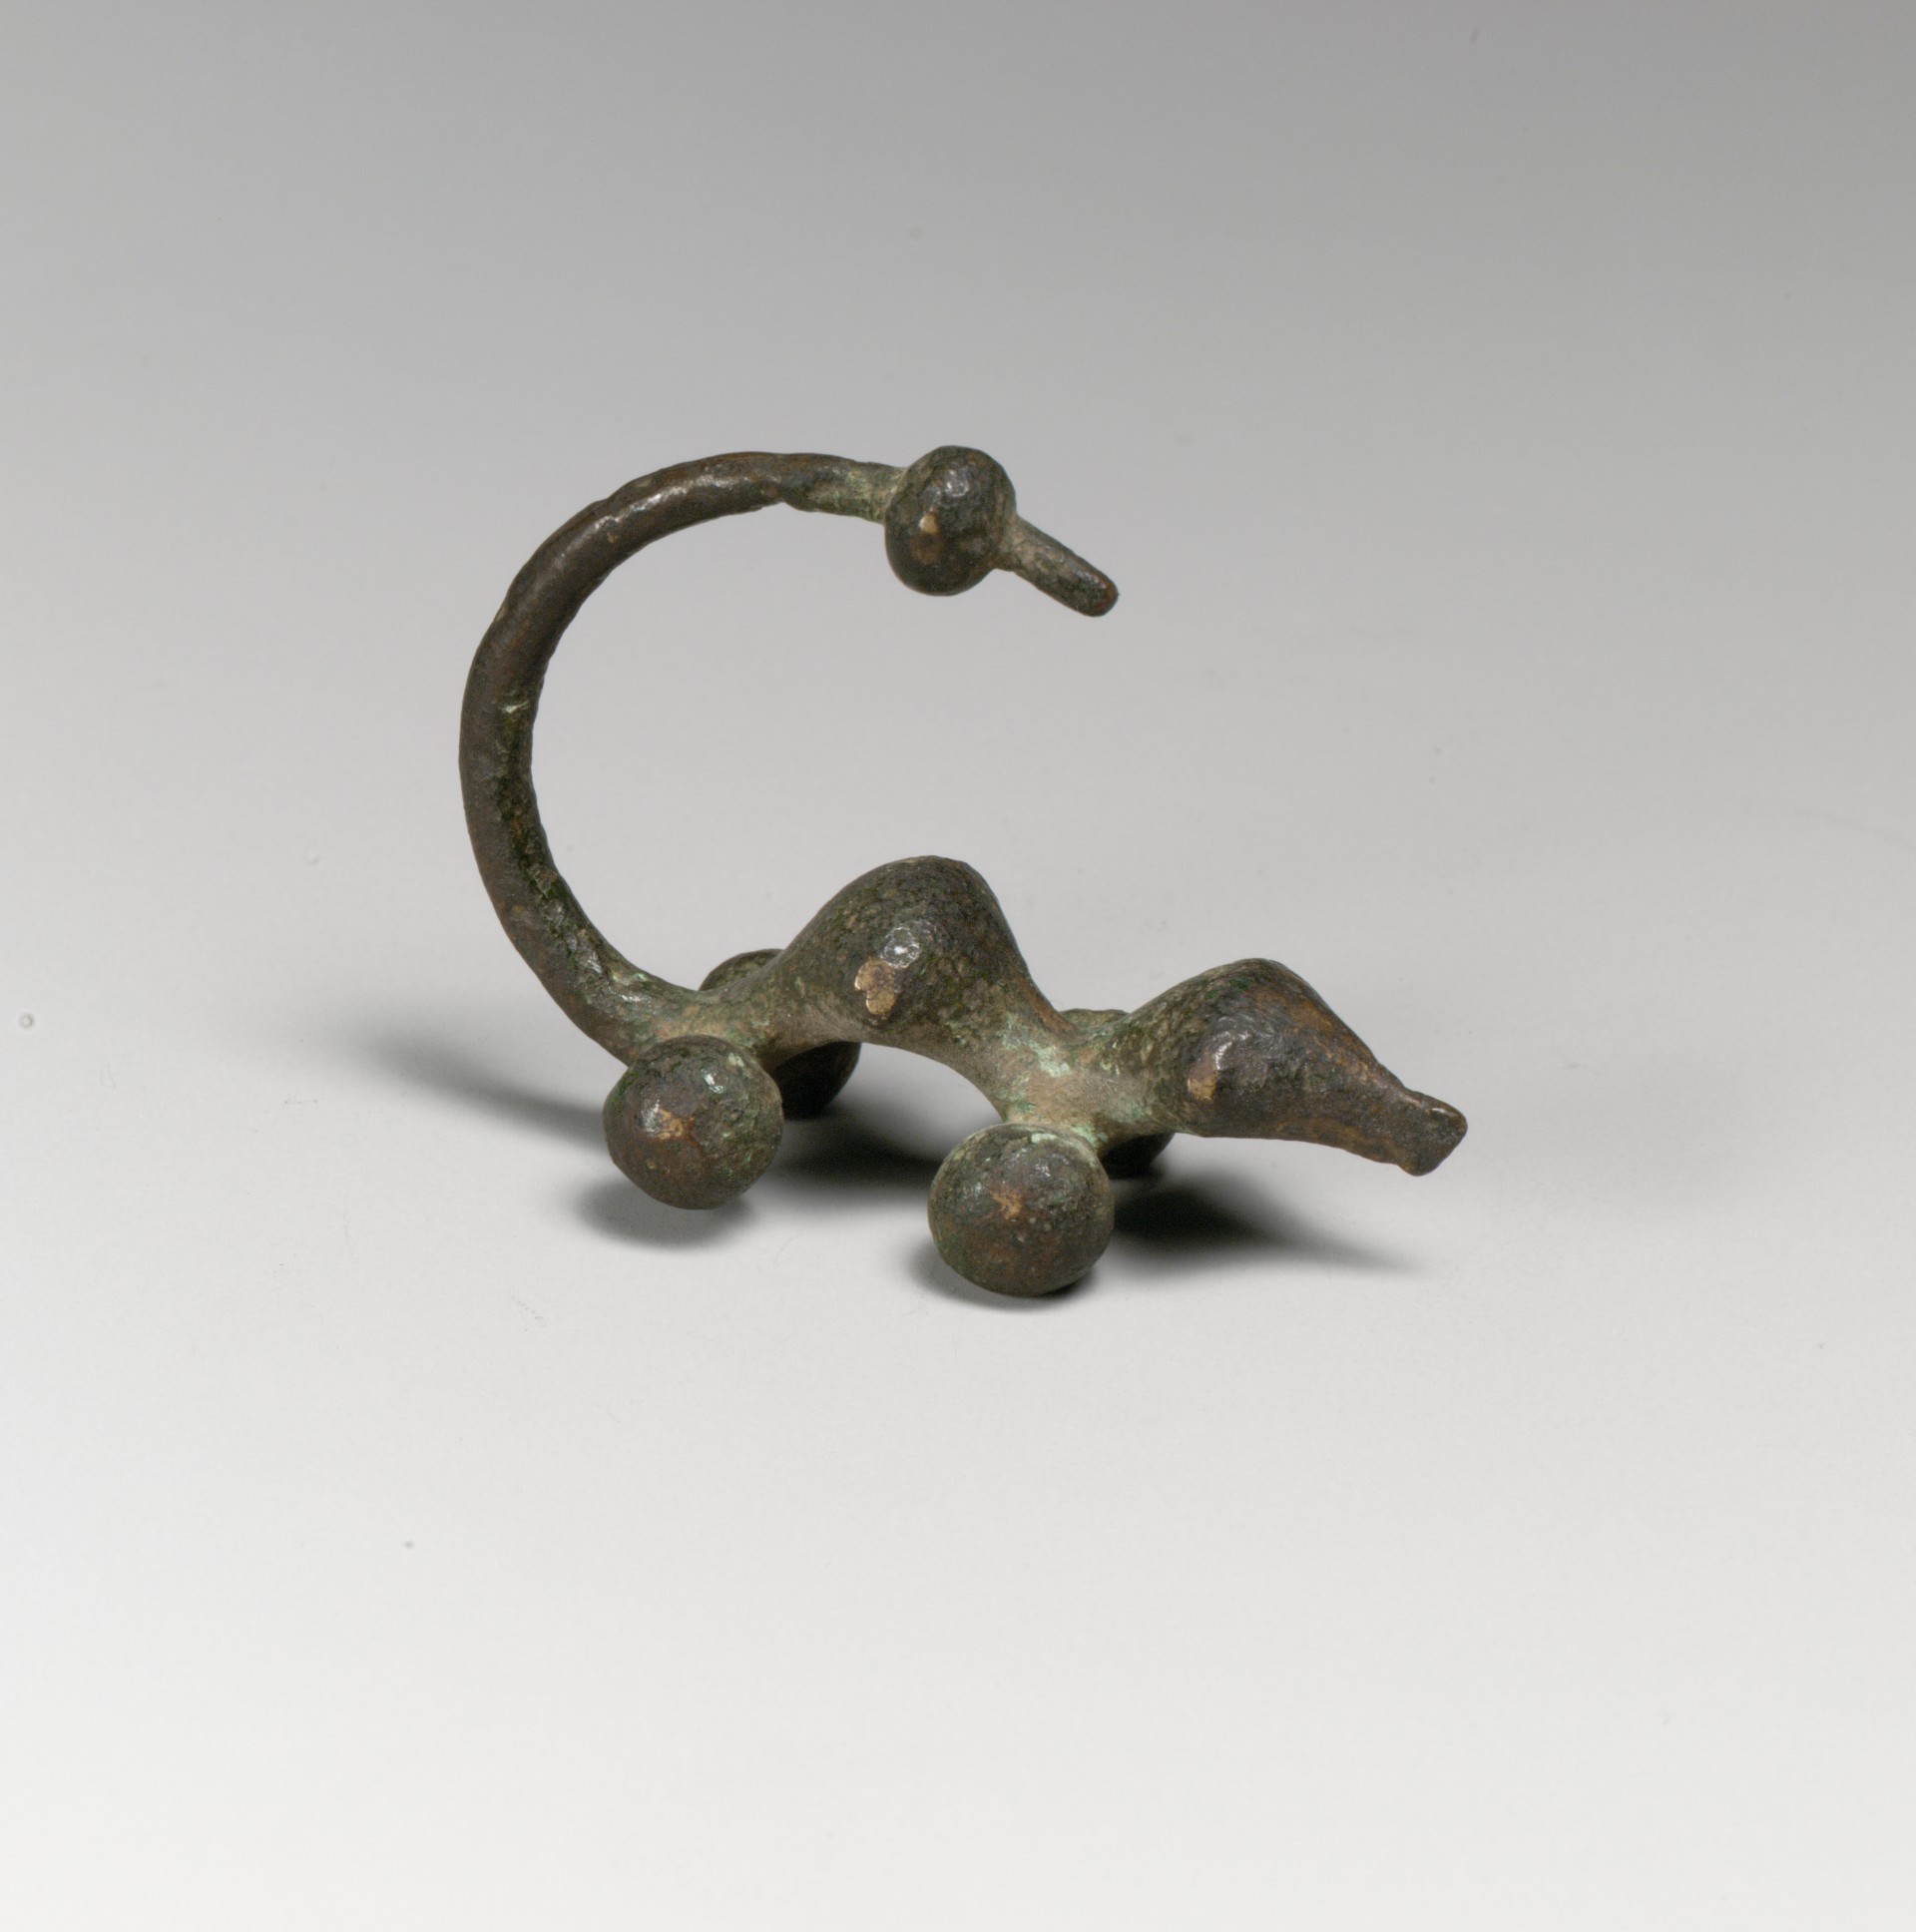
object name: fibula, serpentine type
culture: italic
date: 700-601 BCE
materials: bronze